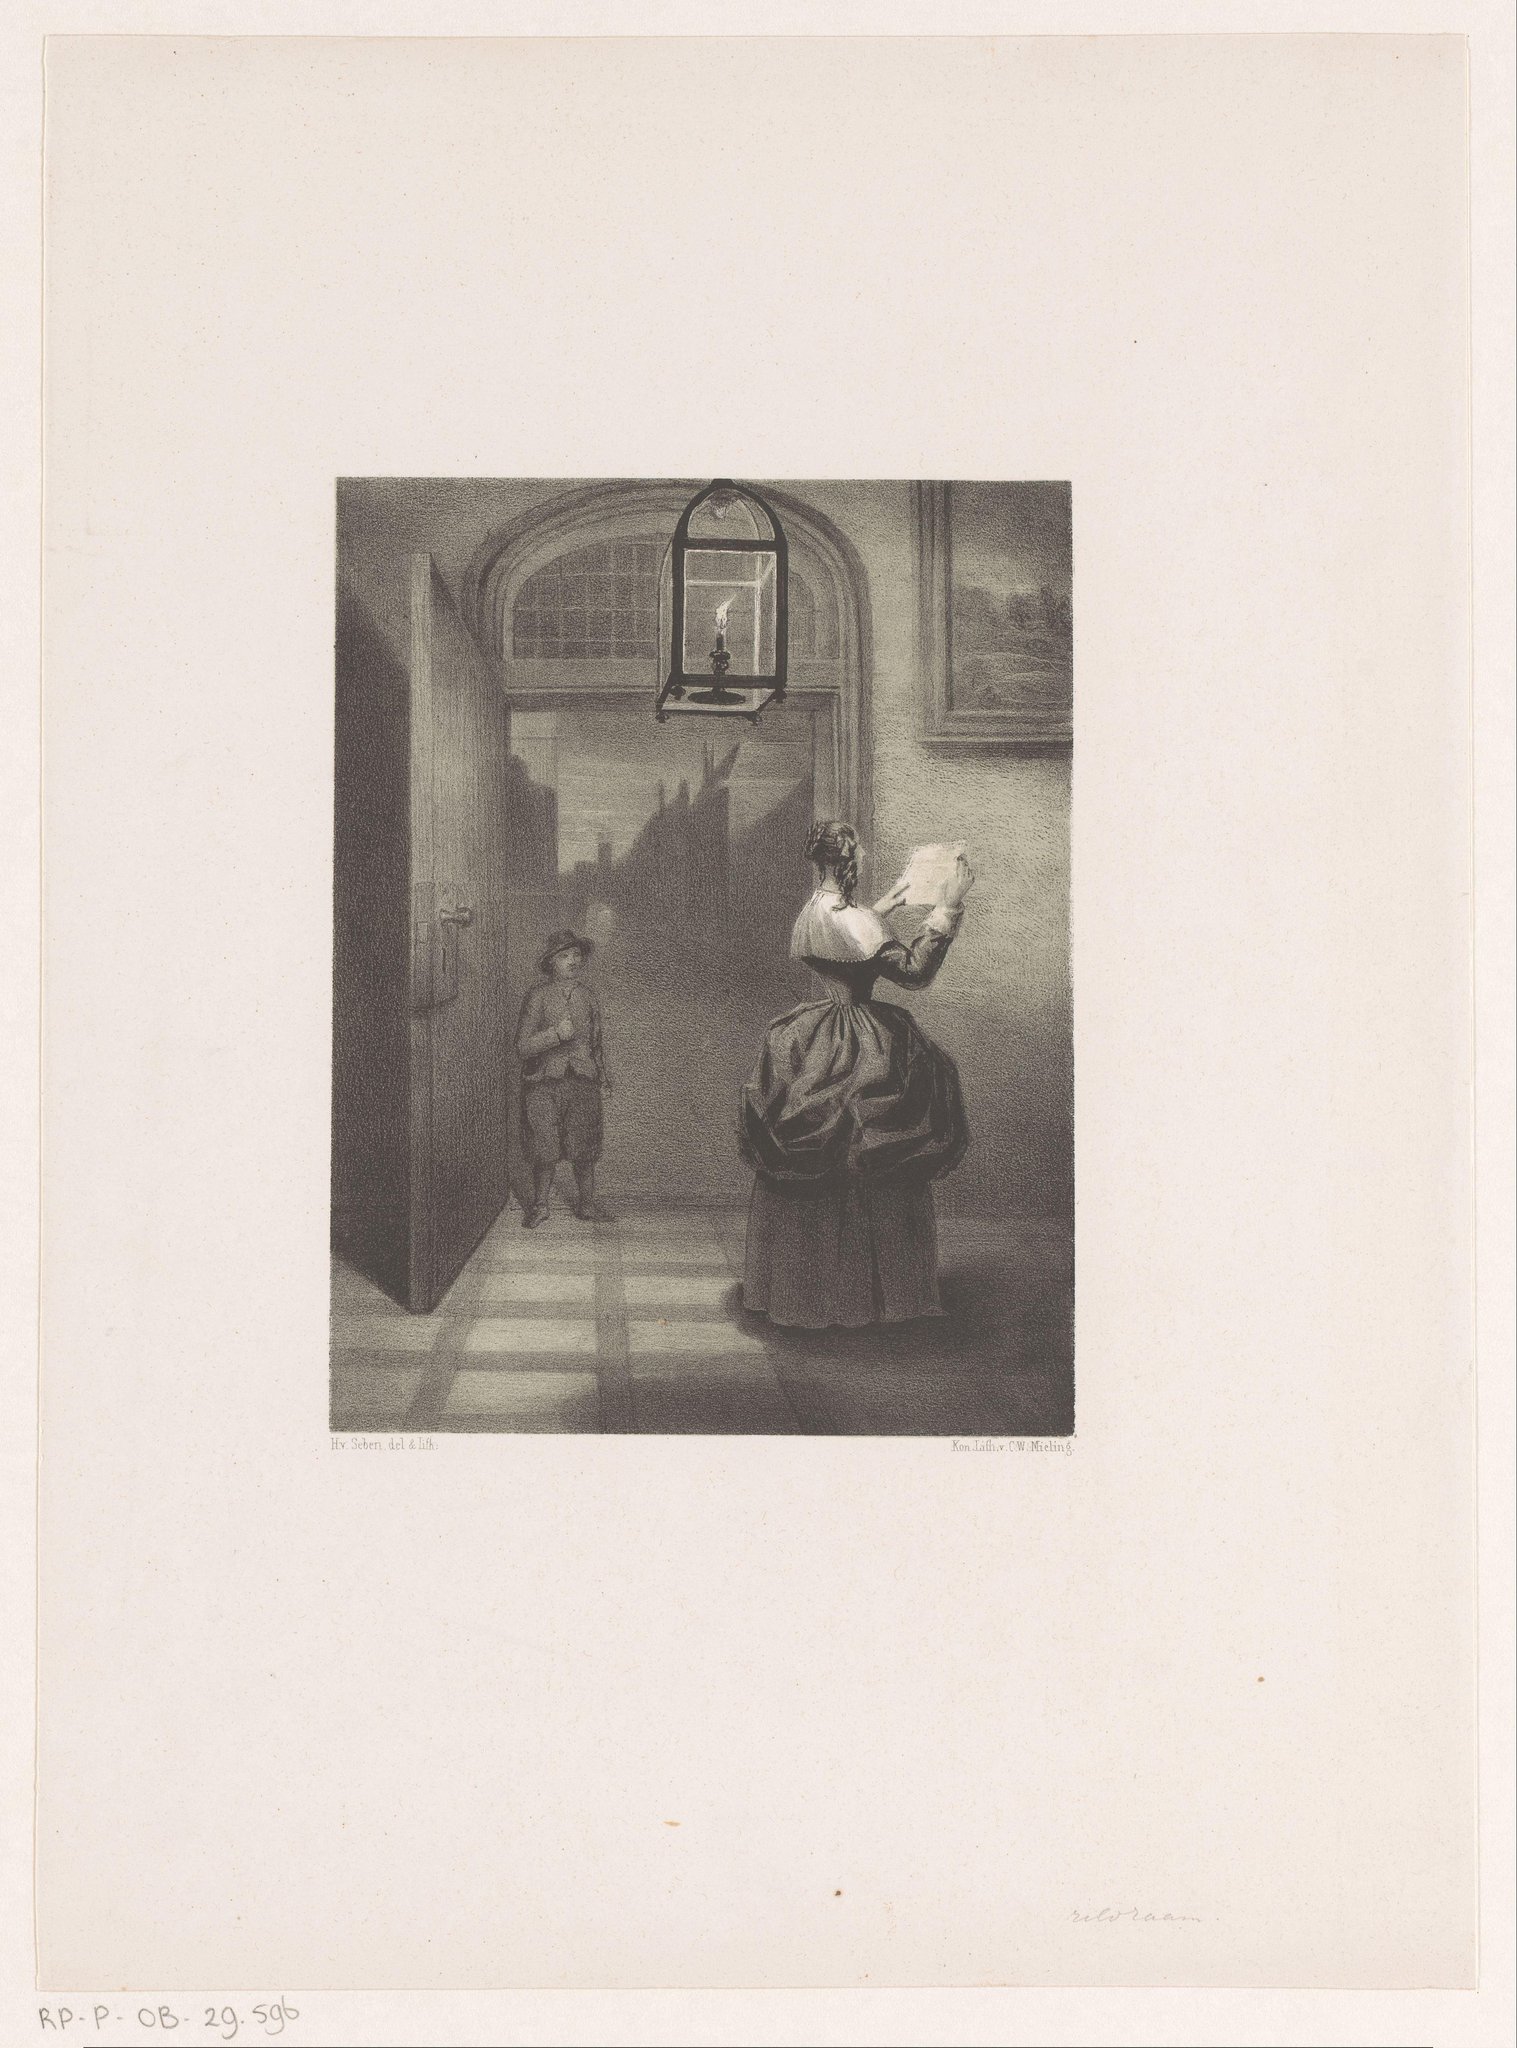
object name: print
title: Brieflezende vrouw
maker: henri van seben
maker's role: print maker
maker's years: 1825-1913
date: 1847-1865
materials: paper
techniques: tone lithography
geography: the hague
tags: reading, letter, envelope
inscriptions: collector's mark: Lugt 2228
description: In een interieur leest een vrouw een brief bij het licht van een kaars. Bij de open deur staat de briefbezorger.